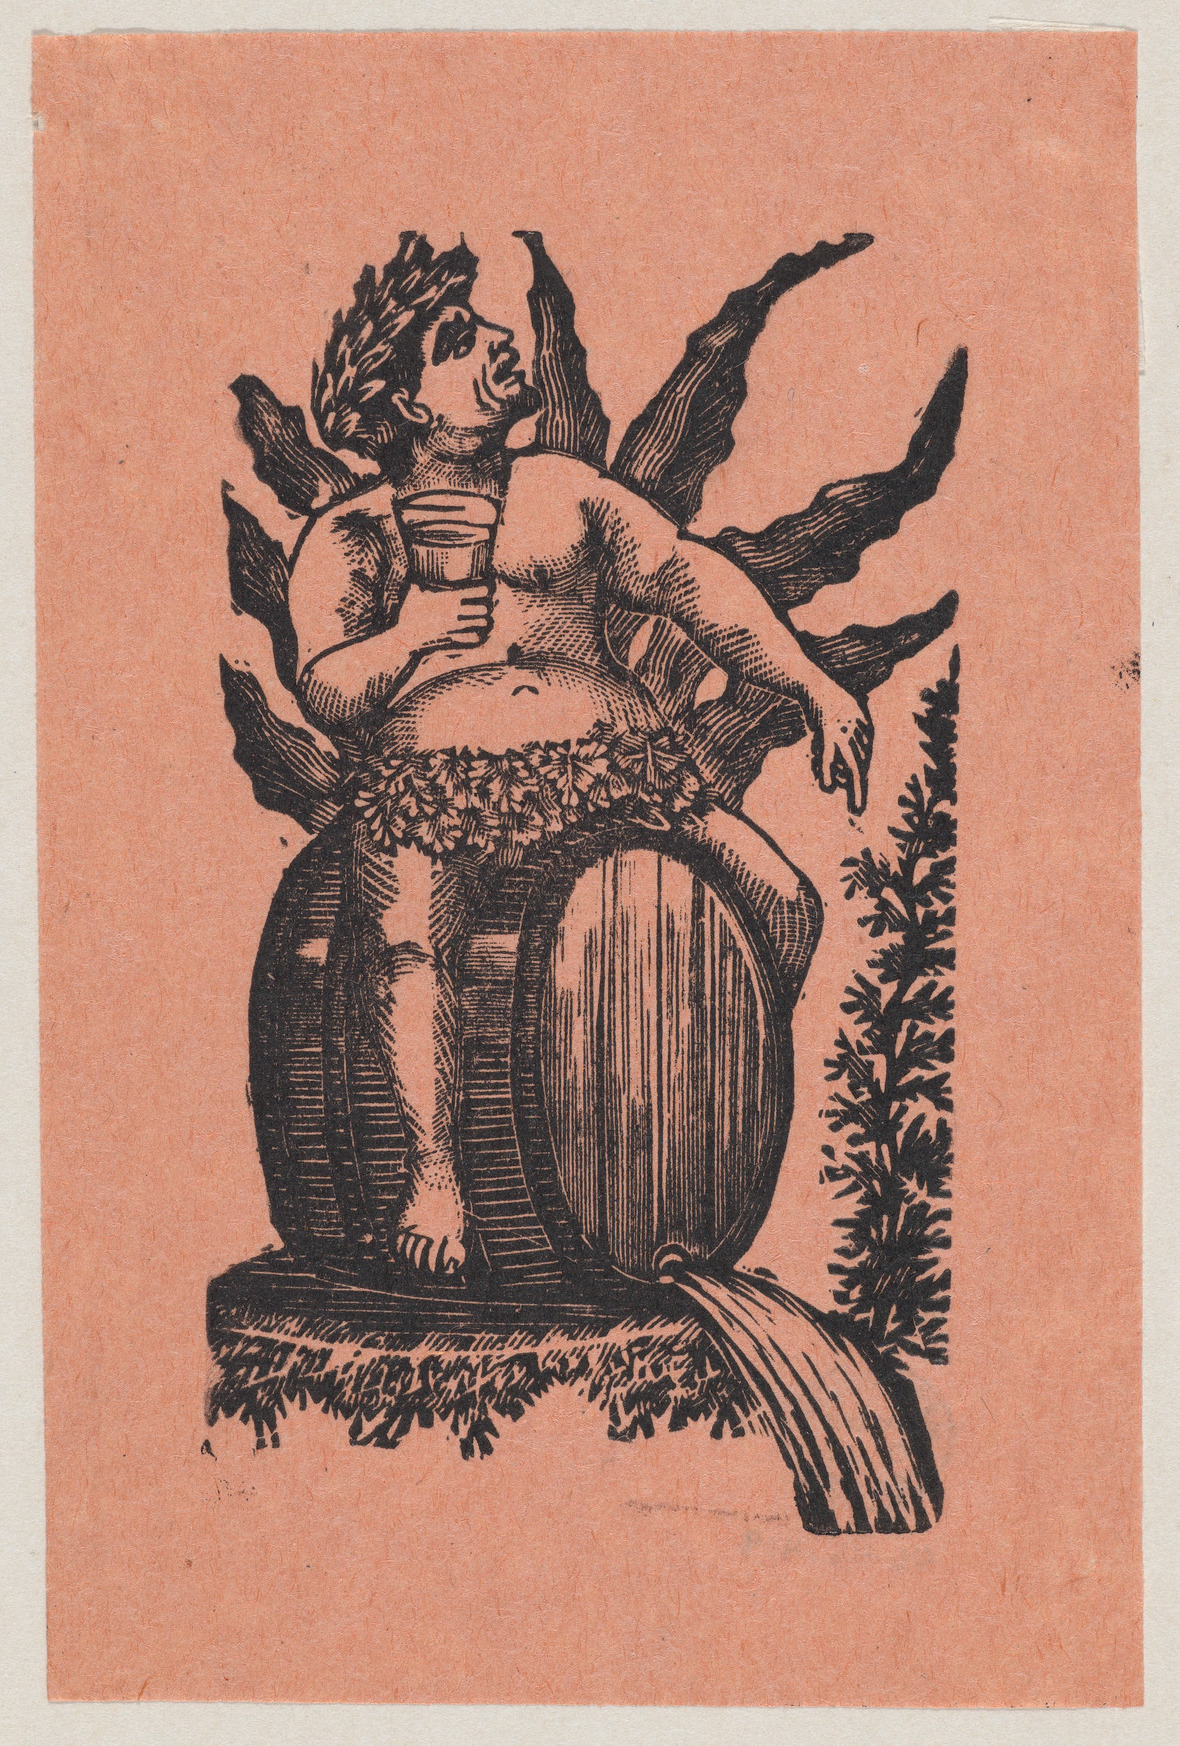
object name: print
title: Bacchus astride a wine barrel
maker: josé guadalupe posada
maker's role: artist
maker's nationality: mexican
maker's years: 1852-1913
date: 1890-1910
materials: metal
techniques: engraving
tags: wine,men,bacchus